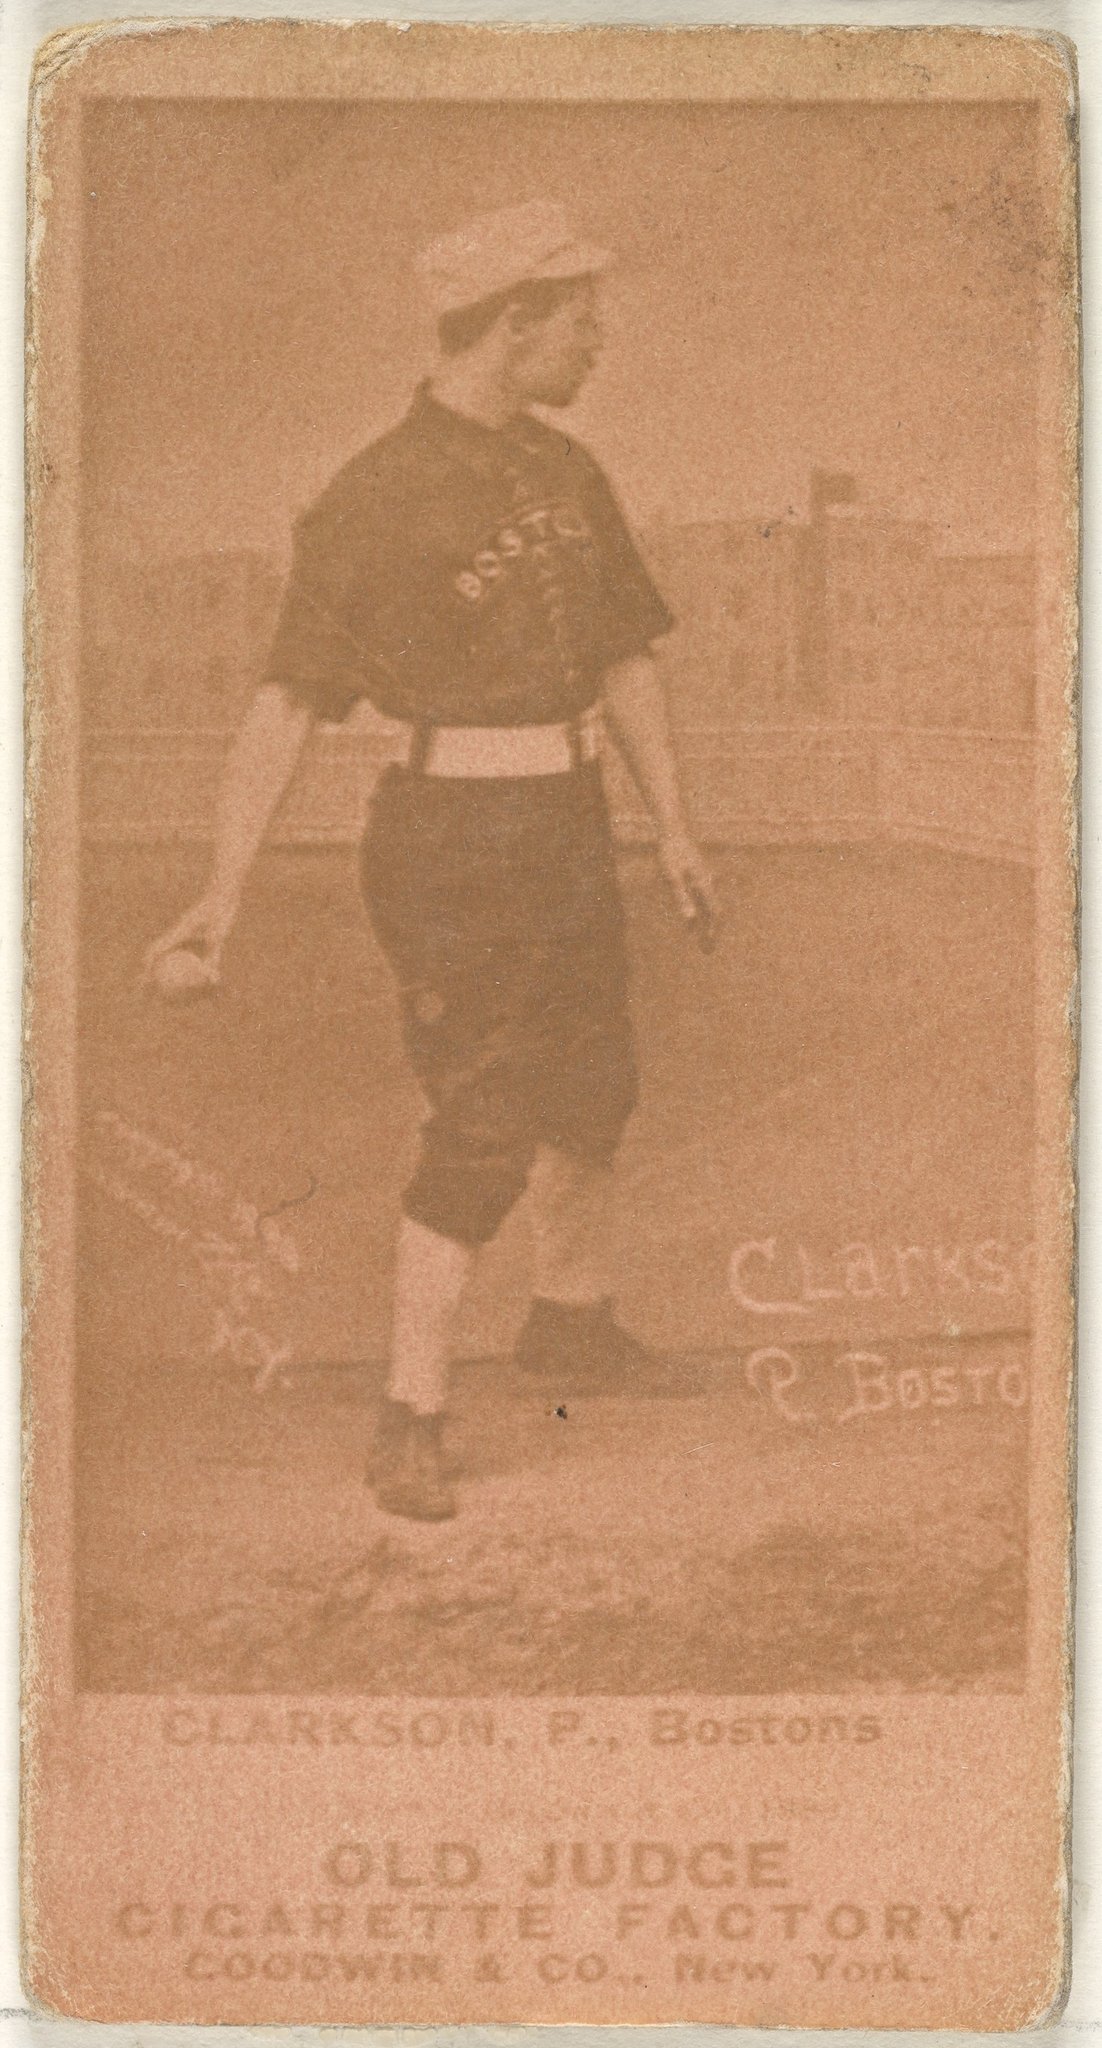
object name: baseball card, photograph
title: Clarkson, Pitcher, Boston, from the Old Judge series (N172) for Old Judge Cigarettes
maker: goodwin & company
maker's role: publisher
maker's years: 1850-1950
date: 1887-1890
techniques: albumen silver print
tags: men,portraits,baseball,athletes